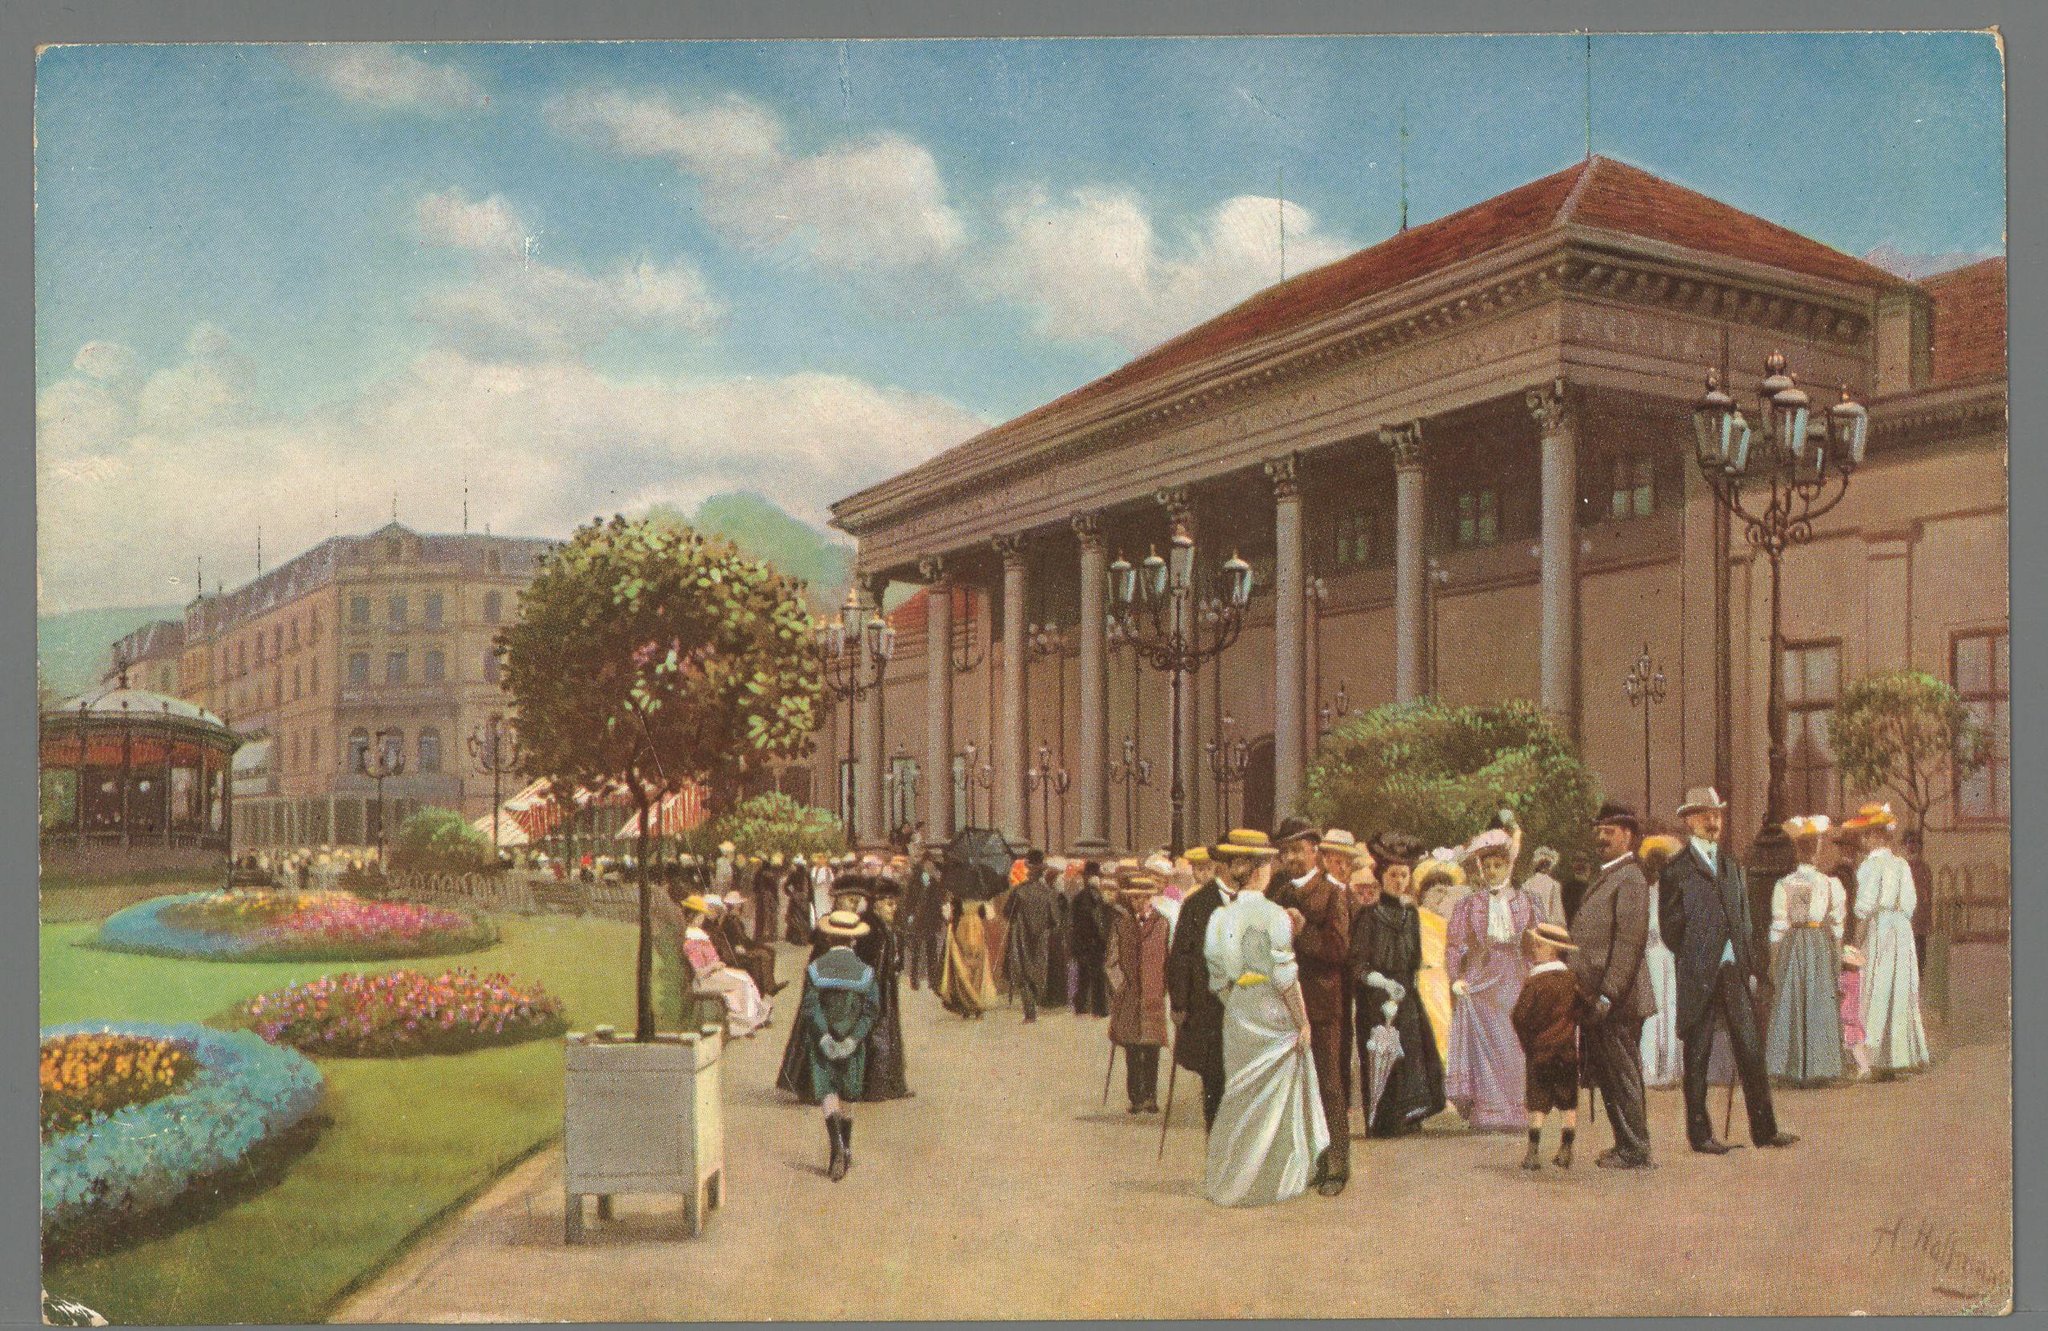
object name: ansichtkaart, prentbriefkaart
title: Baden-Baden. Das Konversationshaus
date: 1905-1930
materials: cardboard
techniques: color autotype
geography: heidelberg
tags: watering-place, spa, street